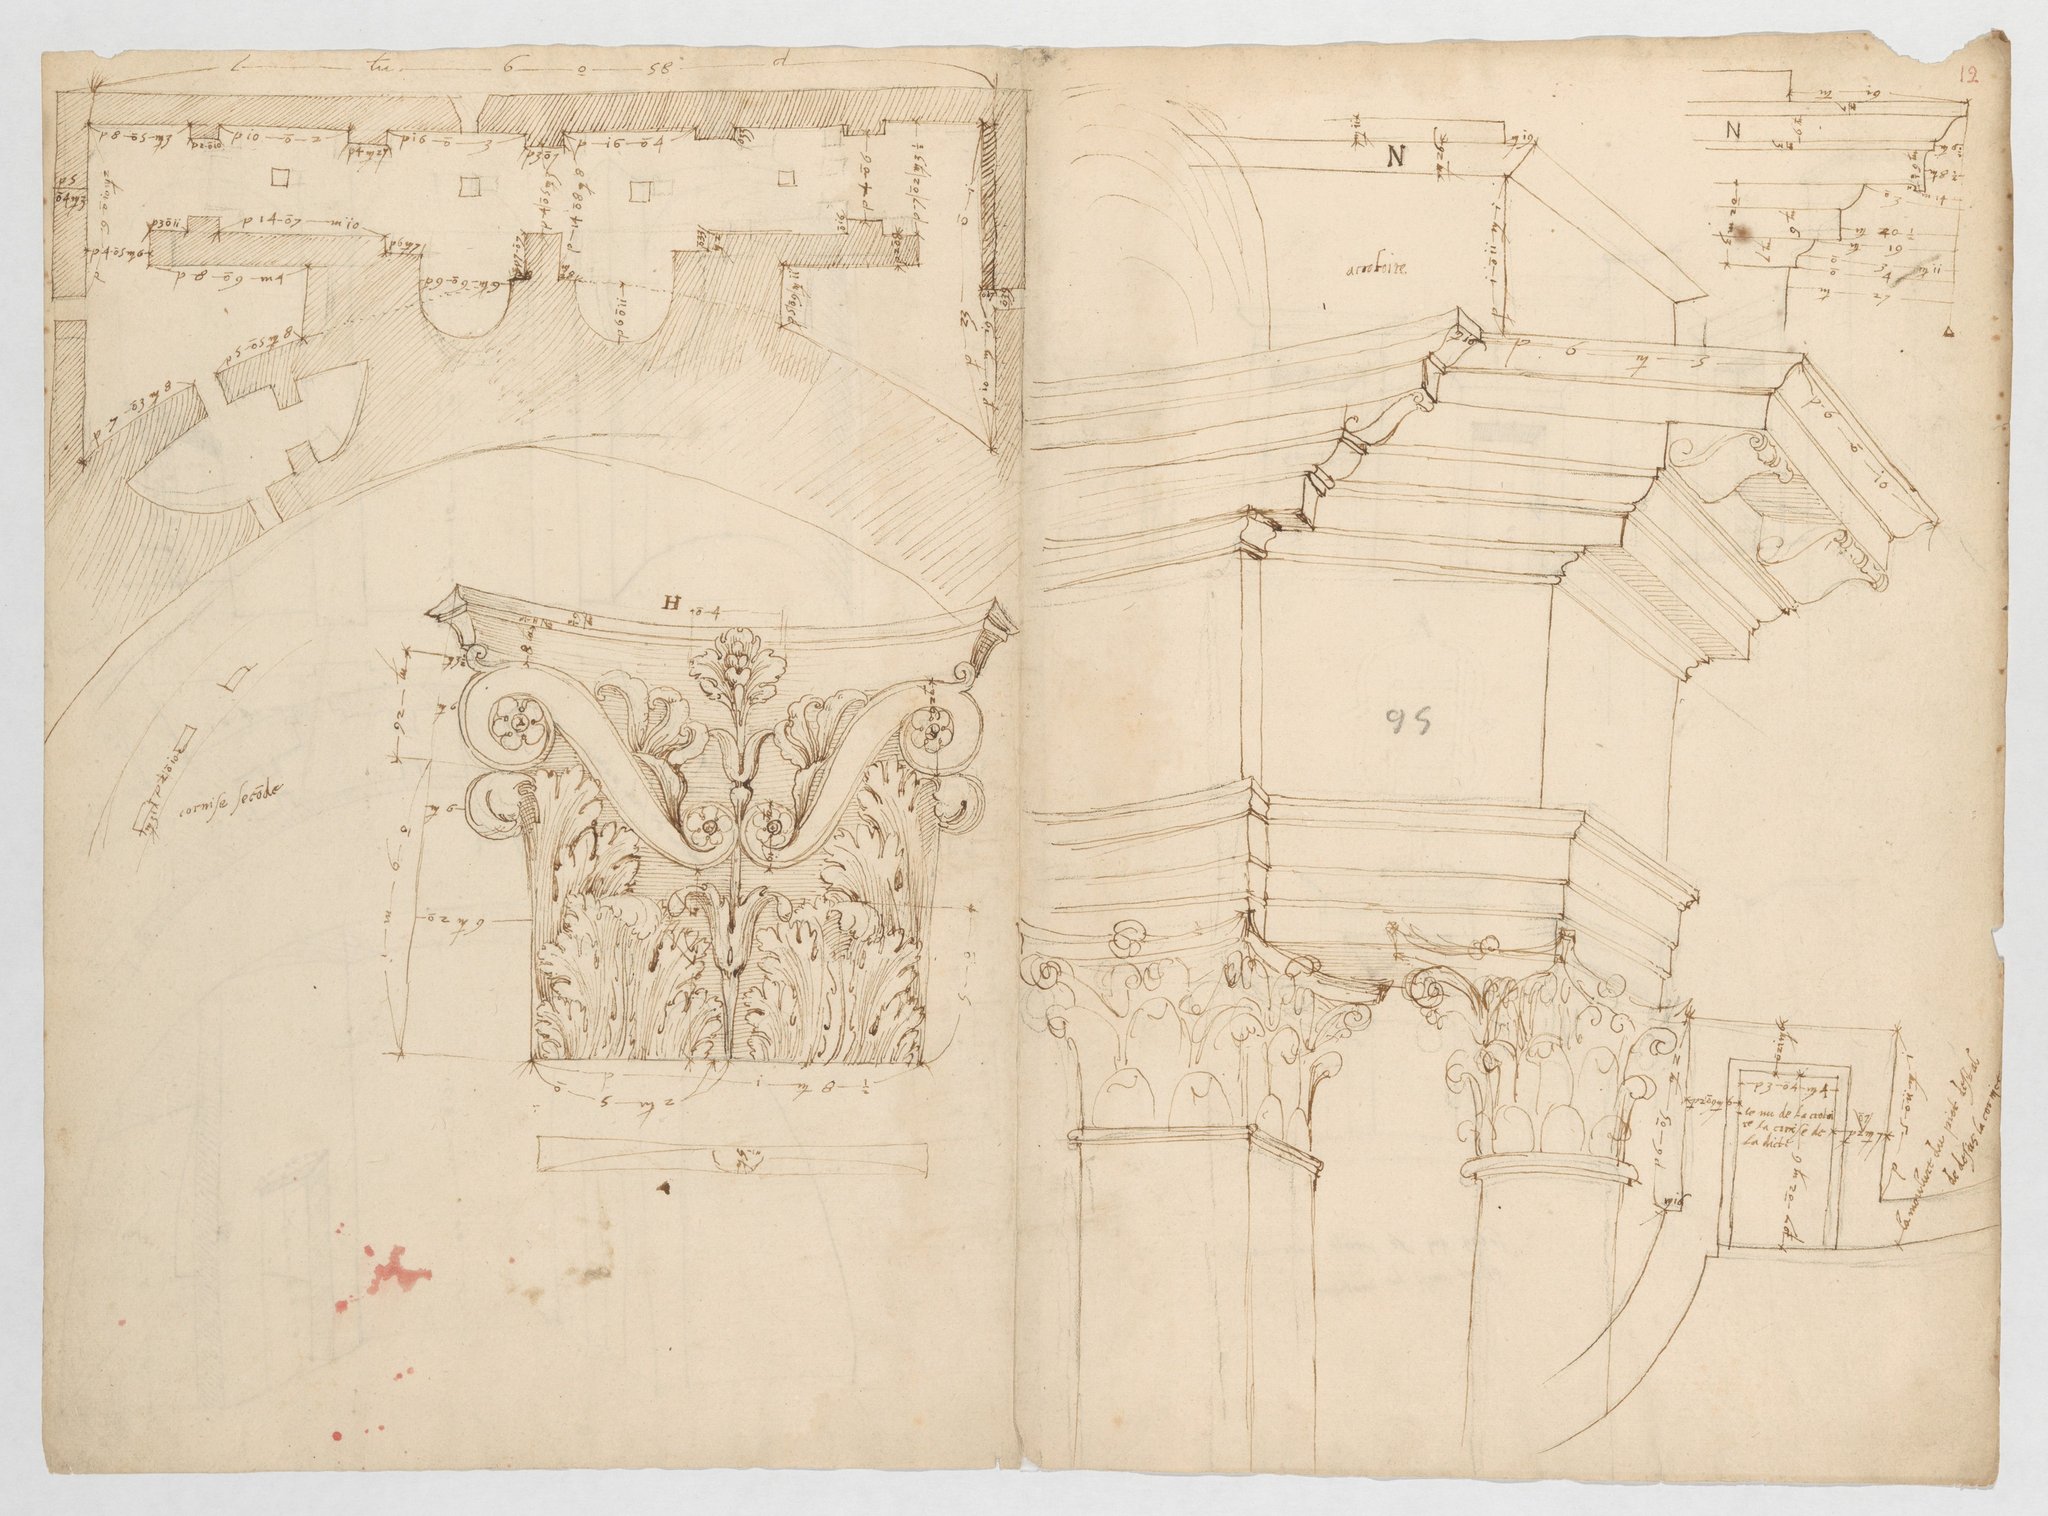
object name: collection ornament architecture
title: Pantheon, perspective elevation, partial plans, Corinthian pilaster capital and alcove details (recto) Pantheon, perspective sections, alcove elevations, partial plans (verso)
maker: anonymous, french, 16th century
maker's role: draftsman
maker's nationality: french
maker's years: 1500-1600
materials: chalk, ink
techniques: incising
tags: capitals